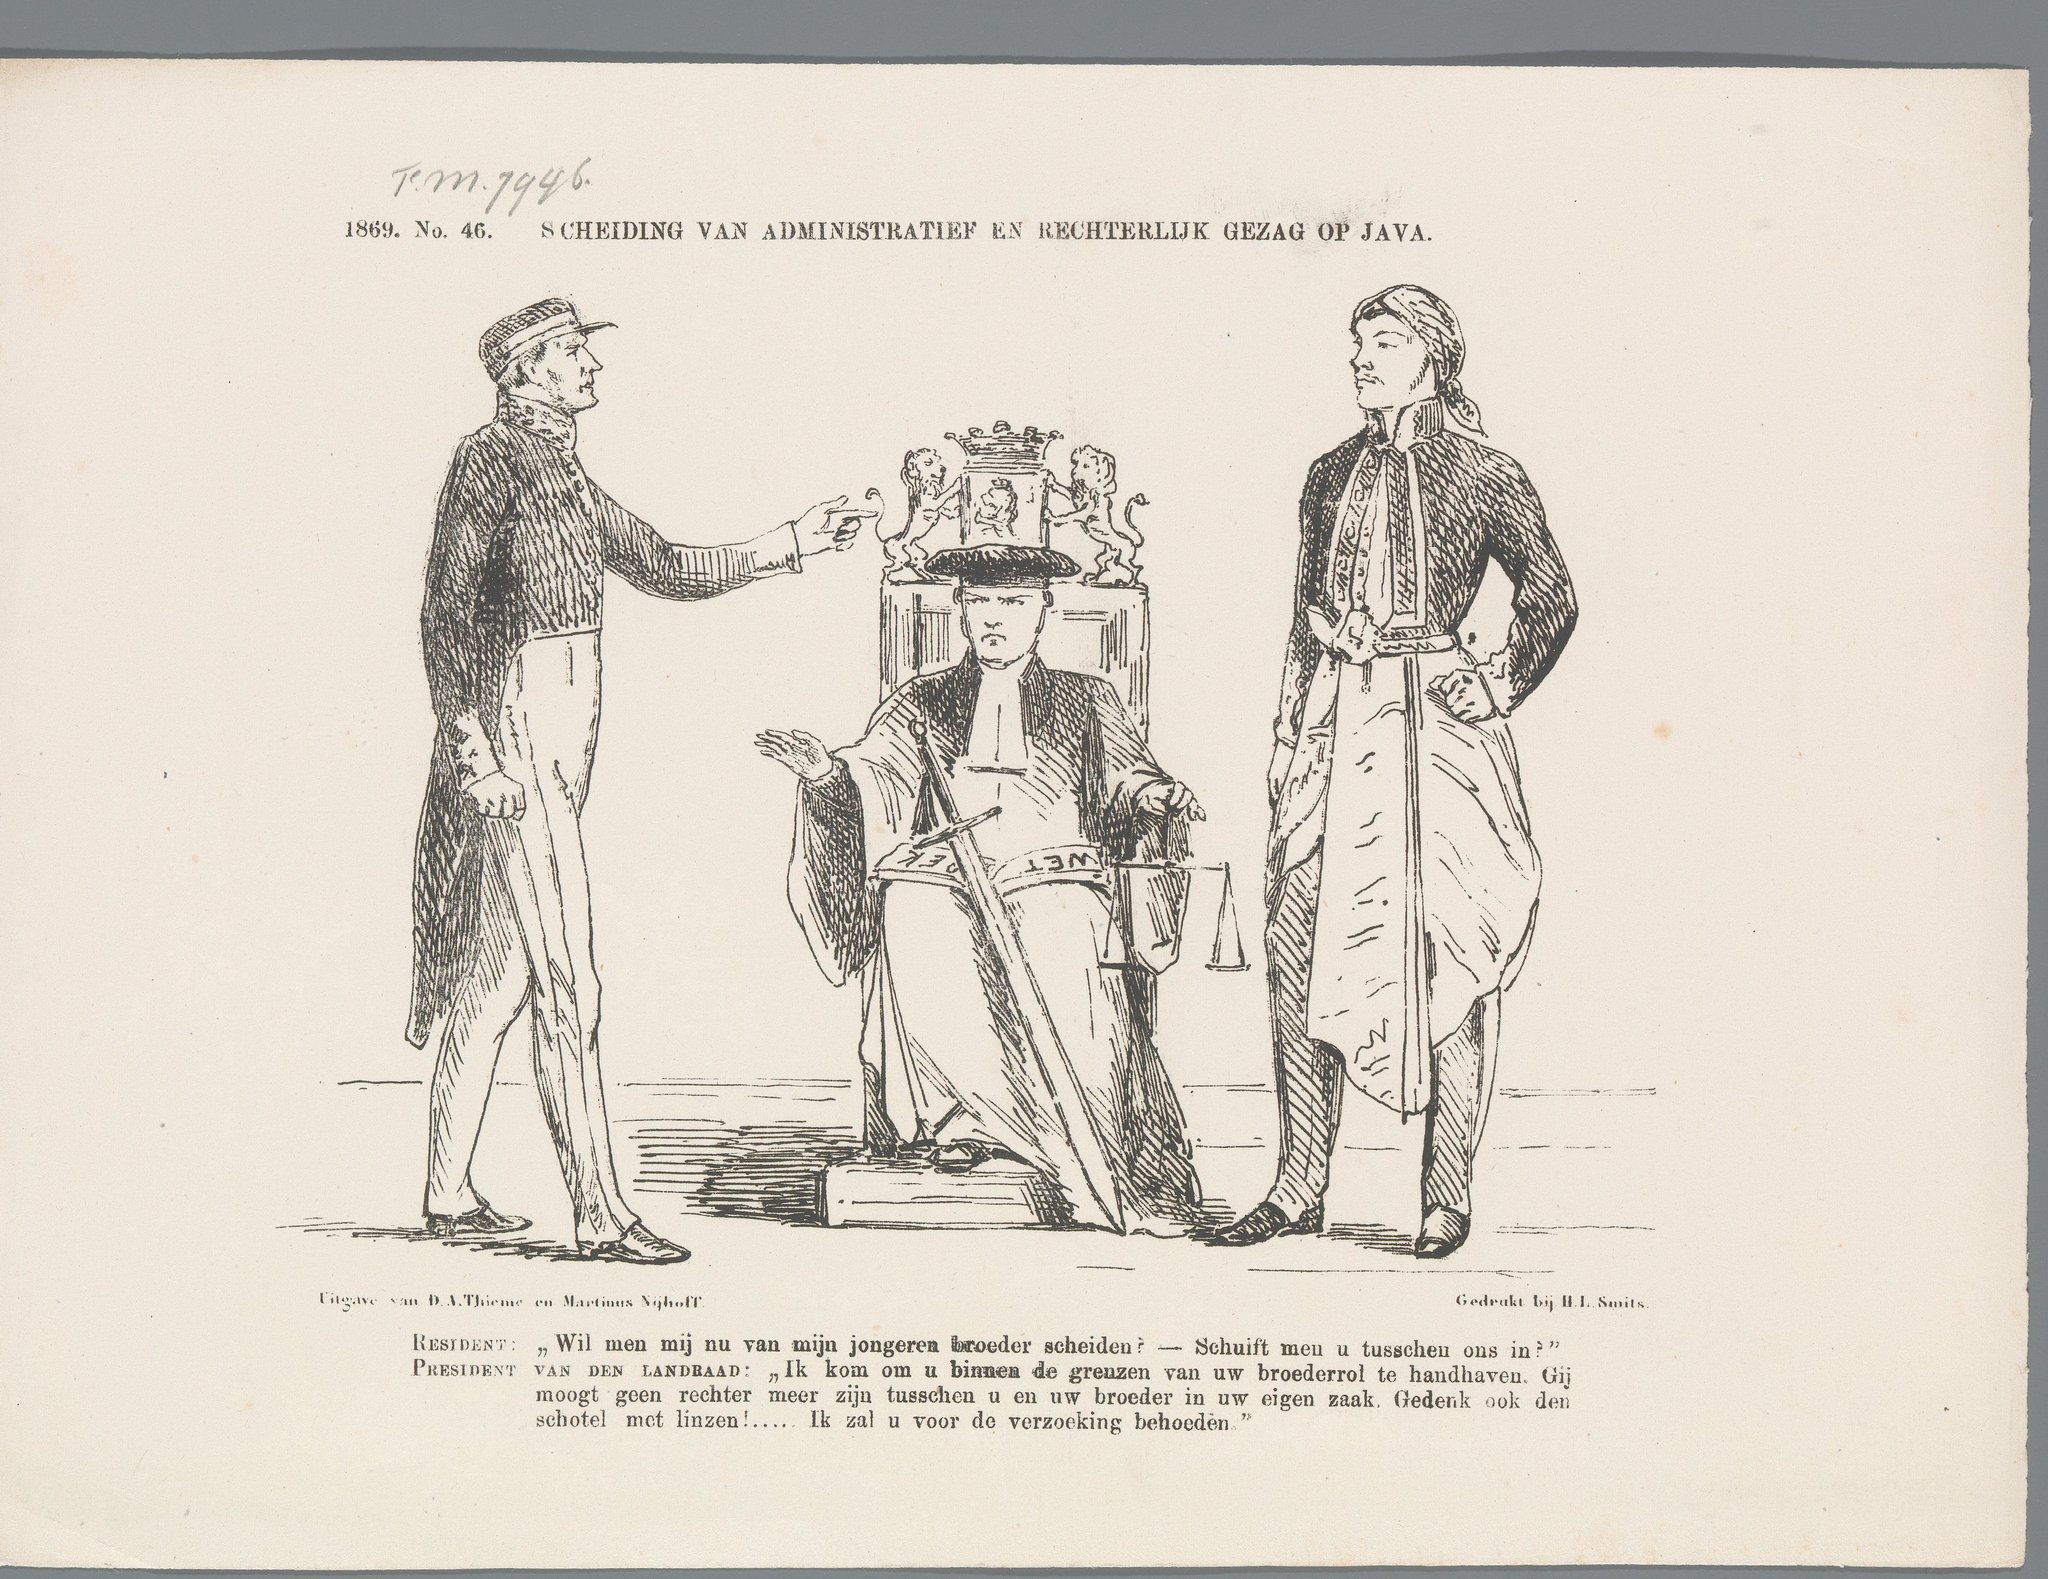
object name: print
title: Scheiding van administratief en rechterlijk gezag op Java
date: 1869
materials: paper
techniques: lithograph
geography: arnhem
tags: magistracy, judges, java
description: Spotprent op de scheiding van administratief en rechterlijk gezag op Java. Plaat verschenen bij het weekblad De Nederlandsche Spectator, nr. 46, 1869.